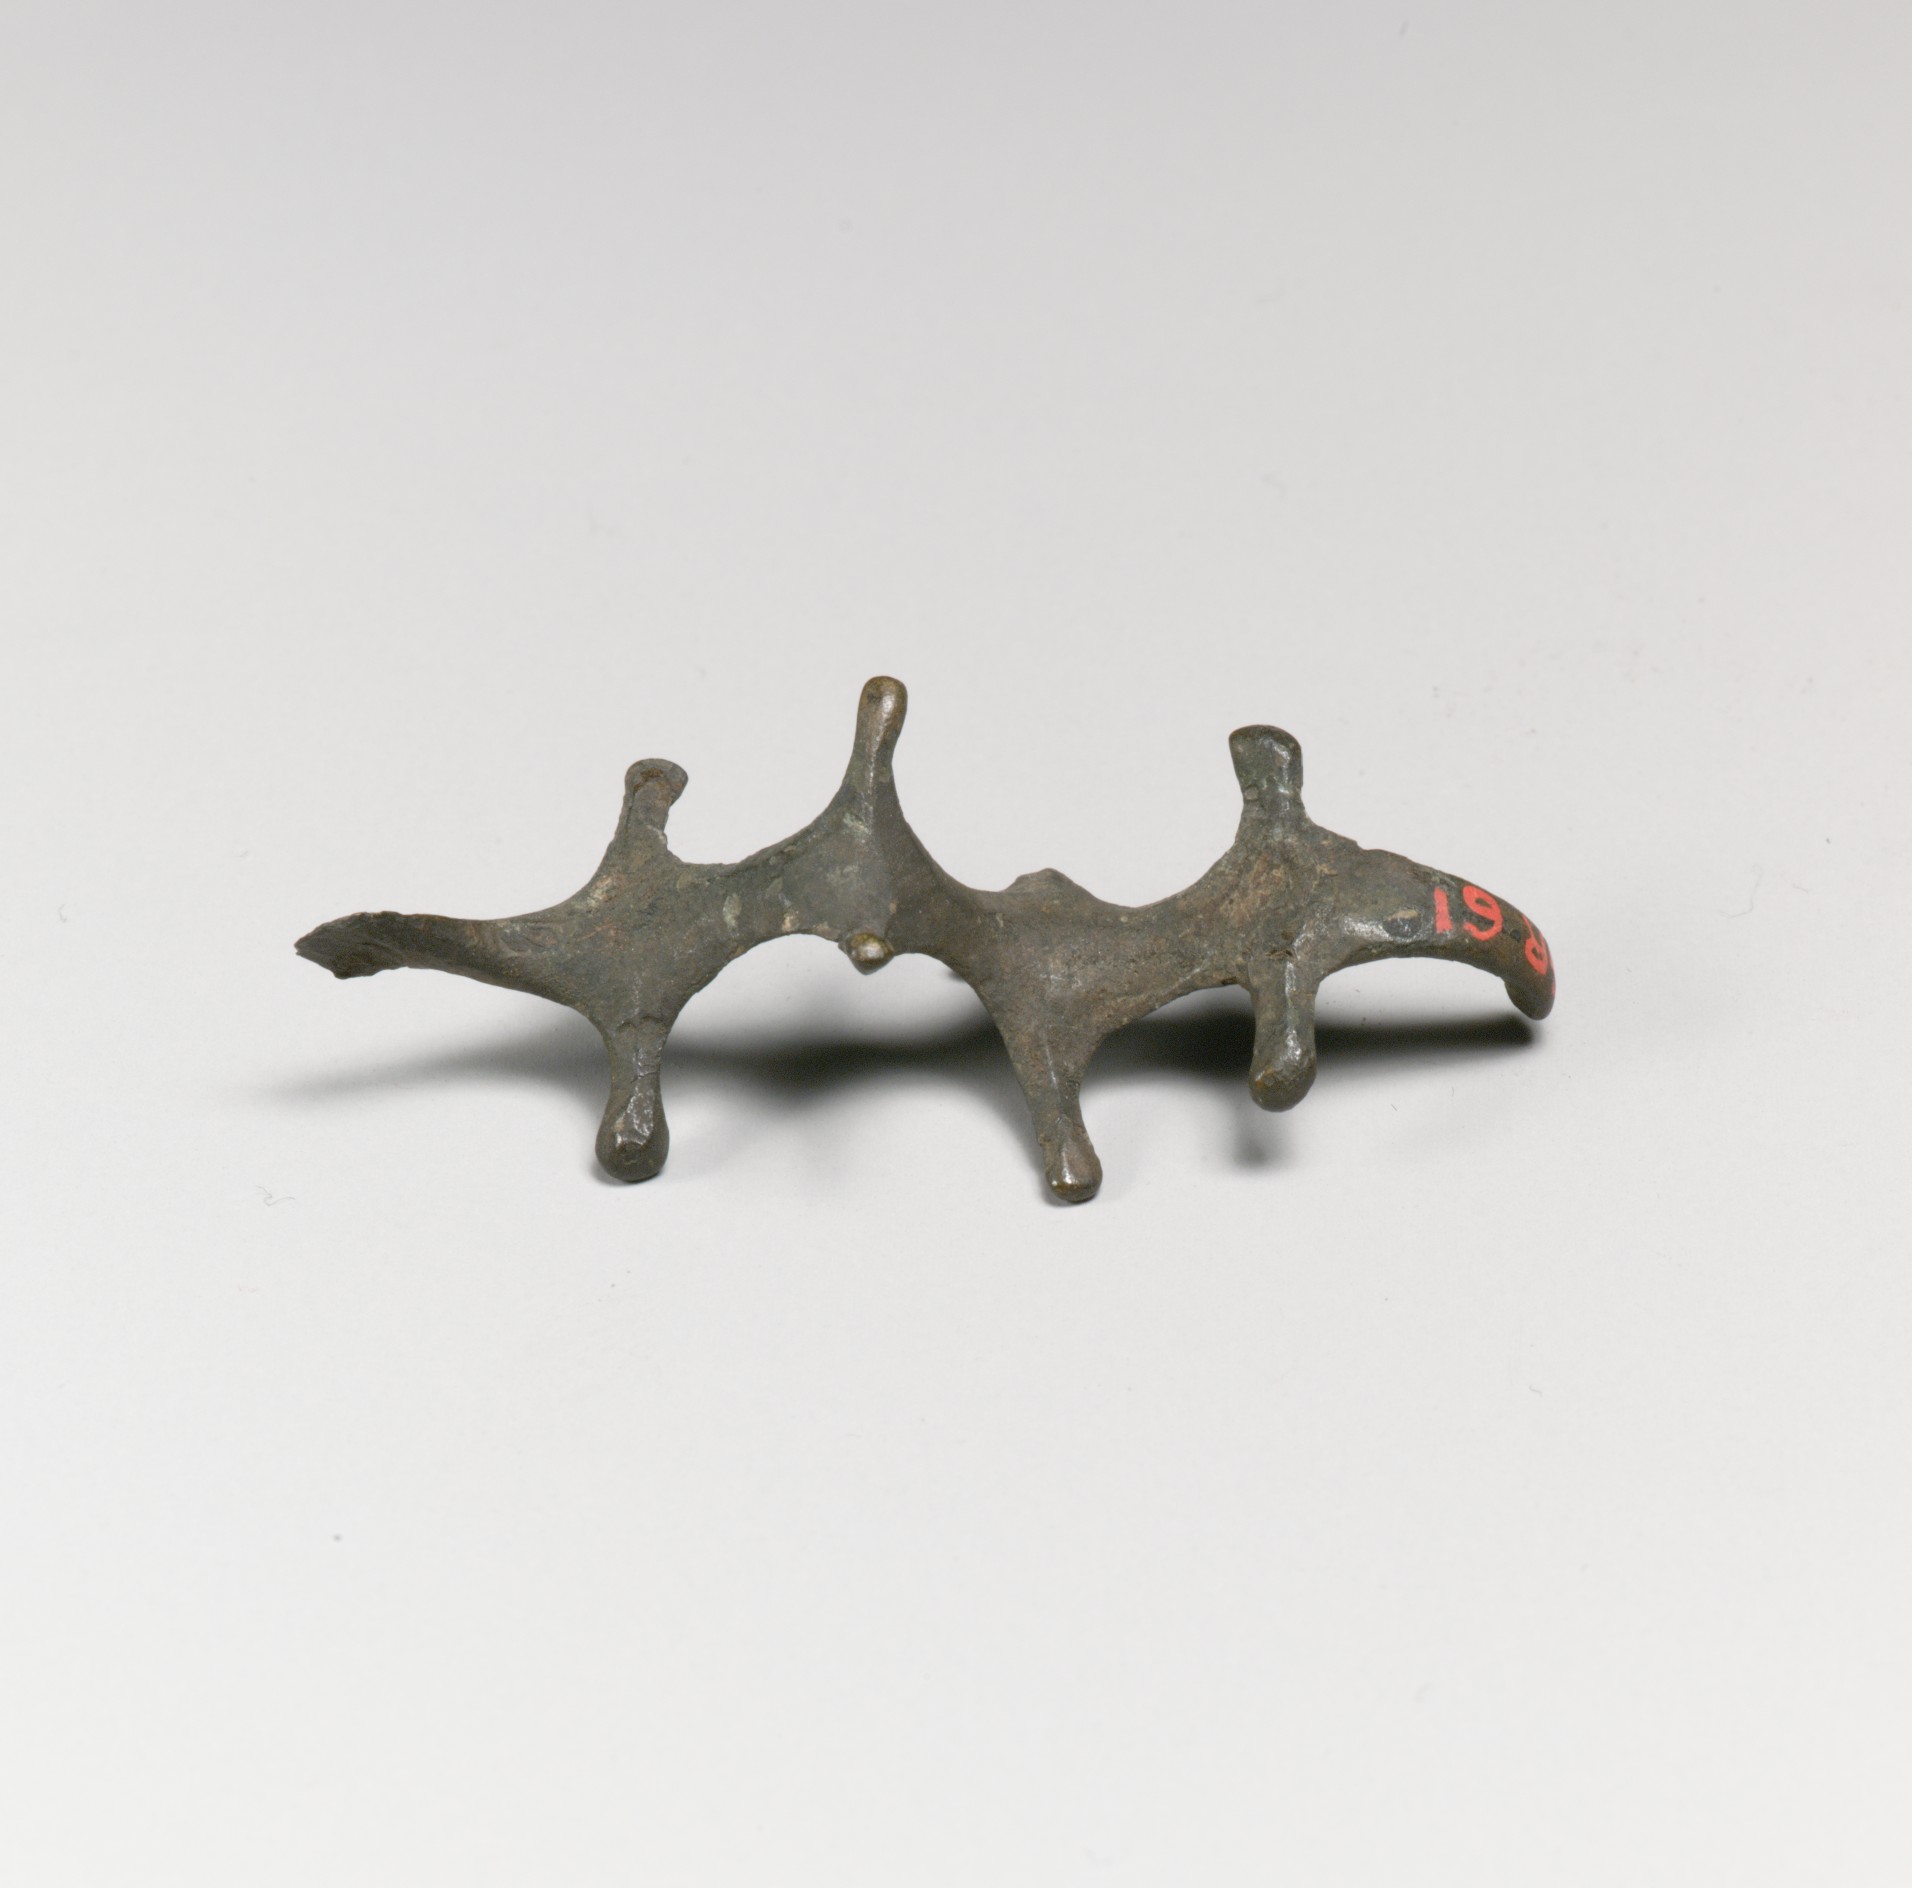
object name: fibula, serpentine type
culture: italic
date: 700-501 BCE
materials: bronze